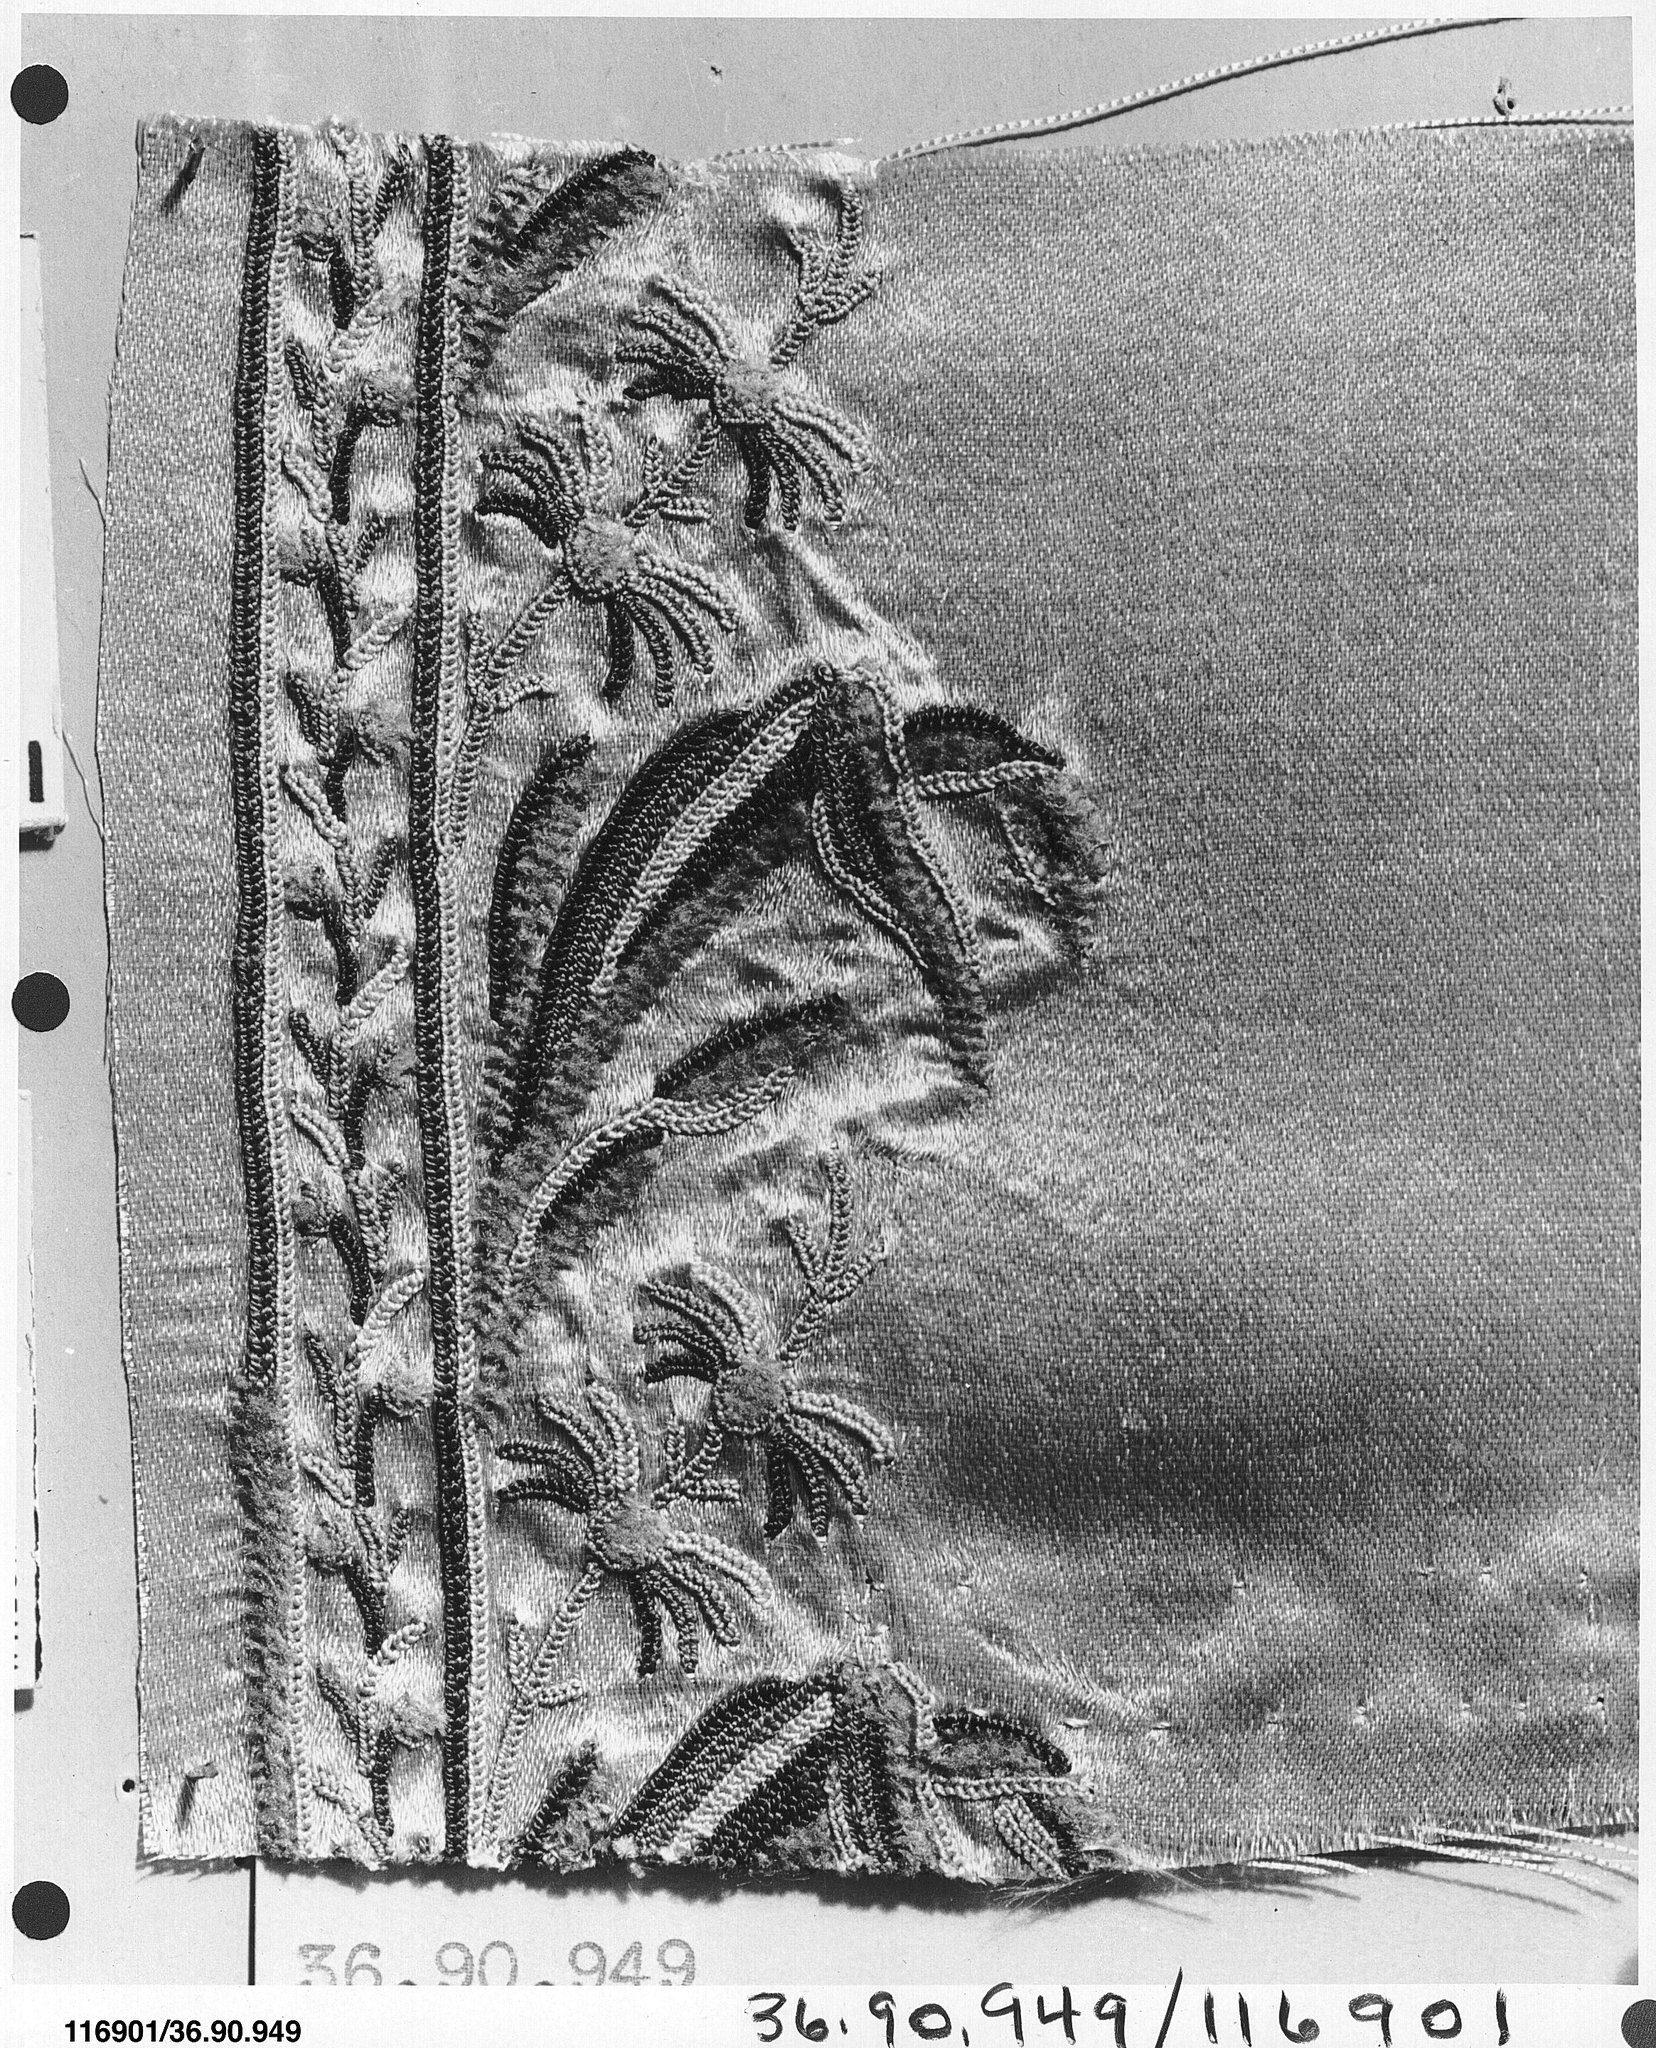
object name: sample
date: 1801-1833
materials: silk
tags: flowers,leaves